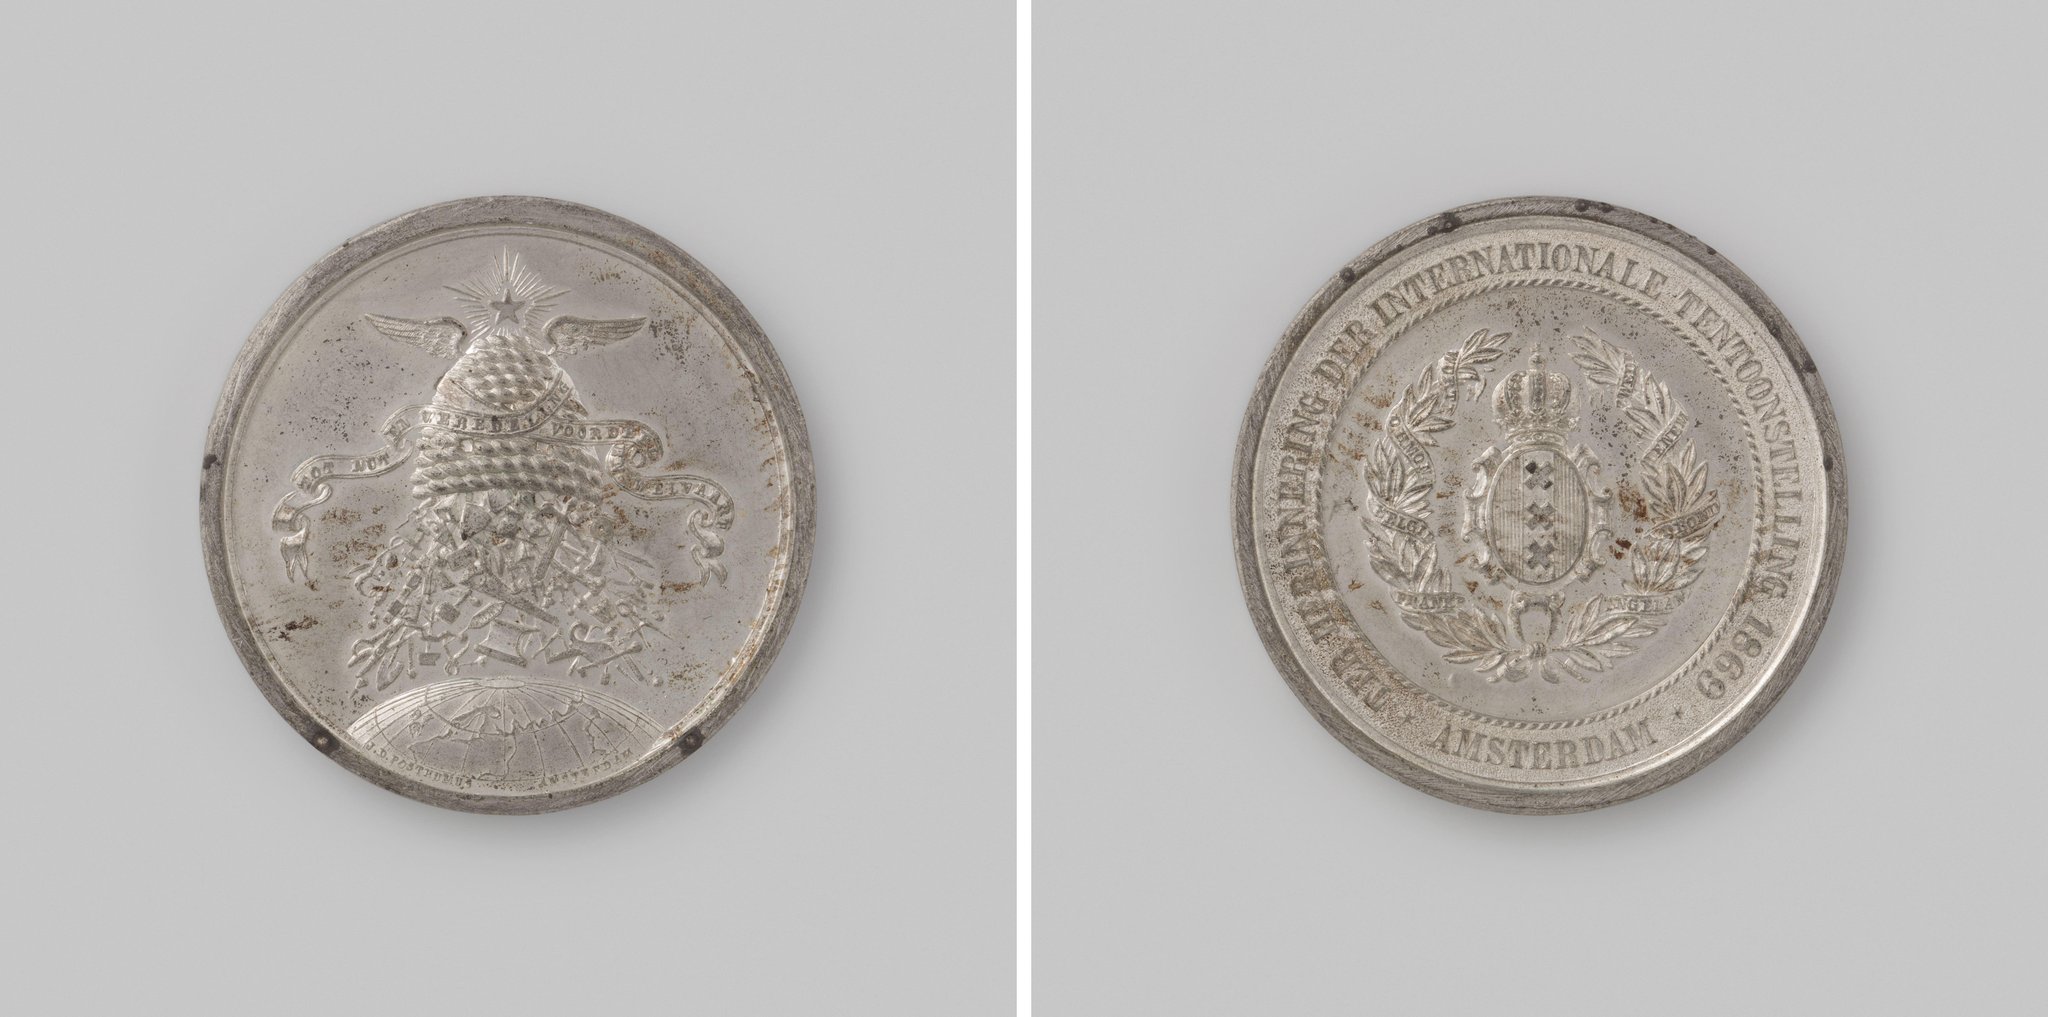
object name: history medal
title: Internationale Tentoonstelling te Amsterdam 1869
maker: jan daniel posthumus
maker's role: medailleur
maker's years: 1838-1919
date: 1869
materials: tin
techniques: striking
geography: amsterdam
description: Tinnen penning, op de voorzijde boven de weredbol een gevleugelde omgekeerde bijenkorf, waaruit gereedschappen vallen, met een tekstlint, op de keerzijde een gekroond ovaal Amsterdams wapenschild tussen samengestrikte lauwertakken waartussen een tekstlint, met omschrift.